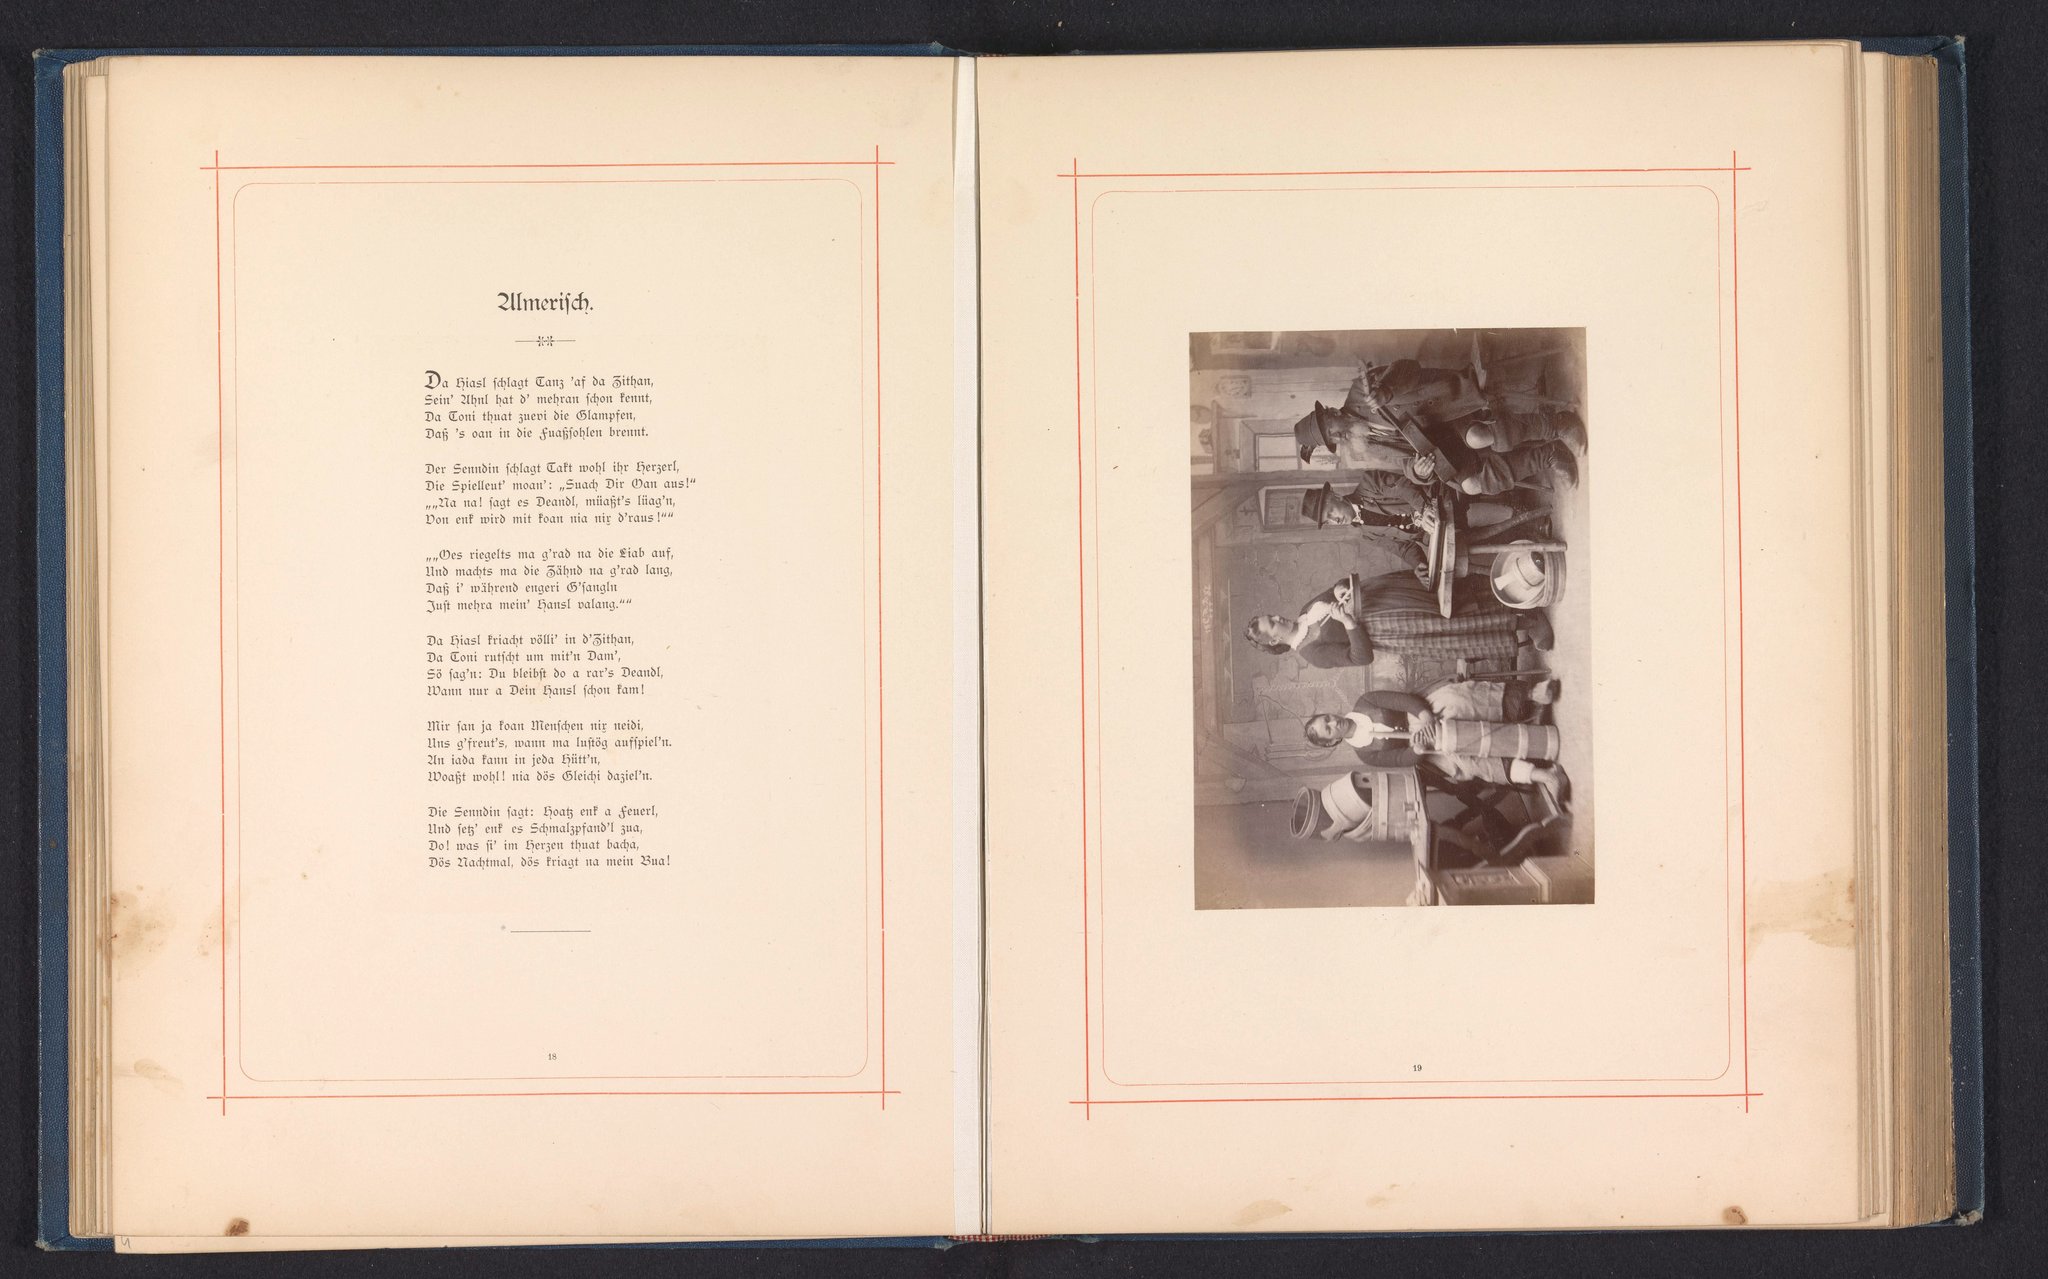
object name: page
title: Twee vrouwen en twee musicerende mannen in klederdracht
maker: max balde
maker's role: fotograaf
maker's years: 1844-1900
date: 1877-1882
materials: photographic support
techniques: albumen print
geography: salzburg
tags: studio ~ photographer, making music; musician with instrument, adult man, churning